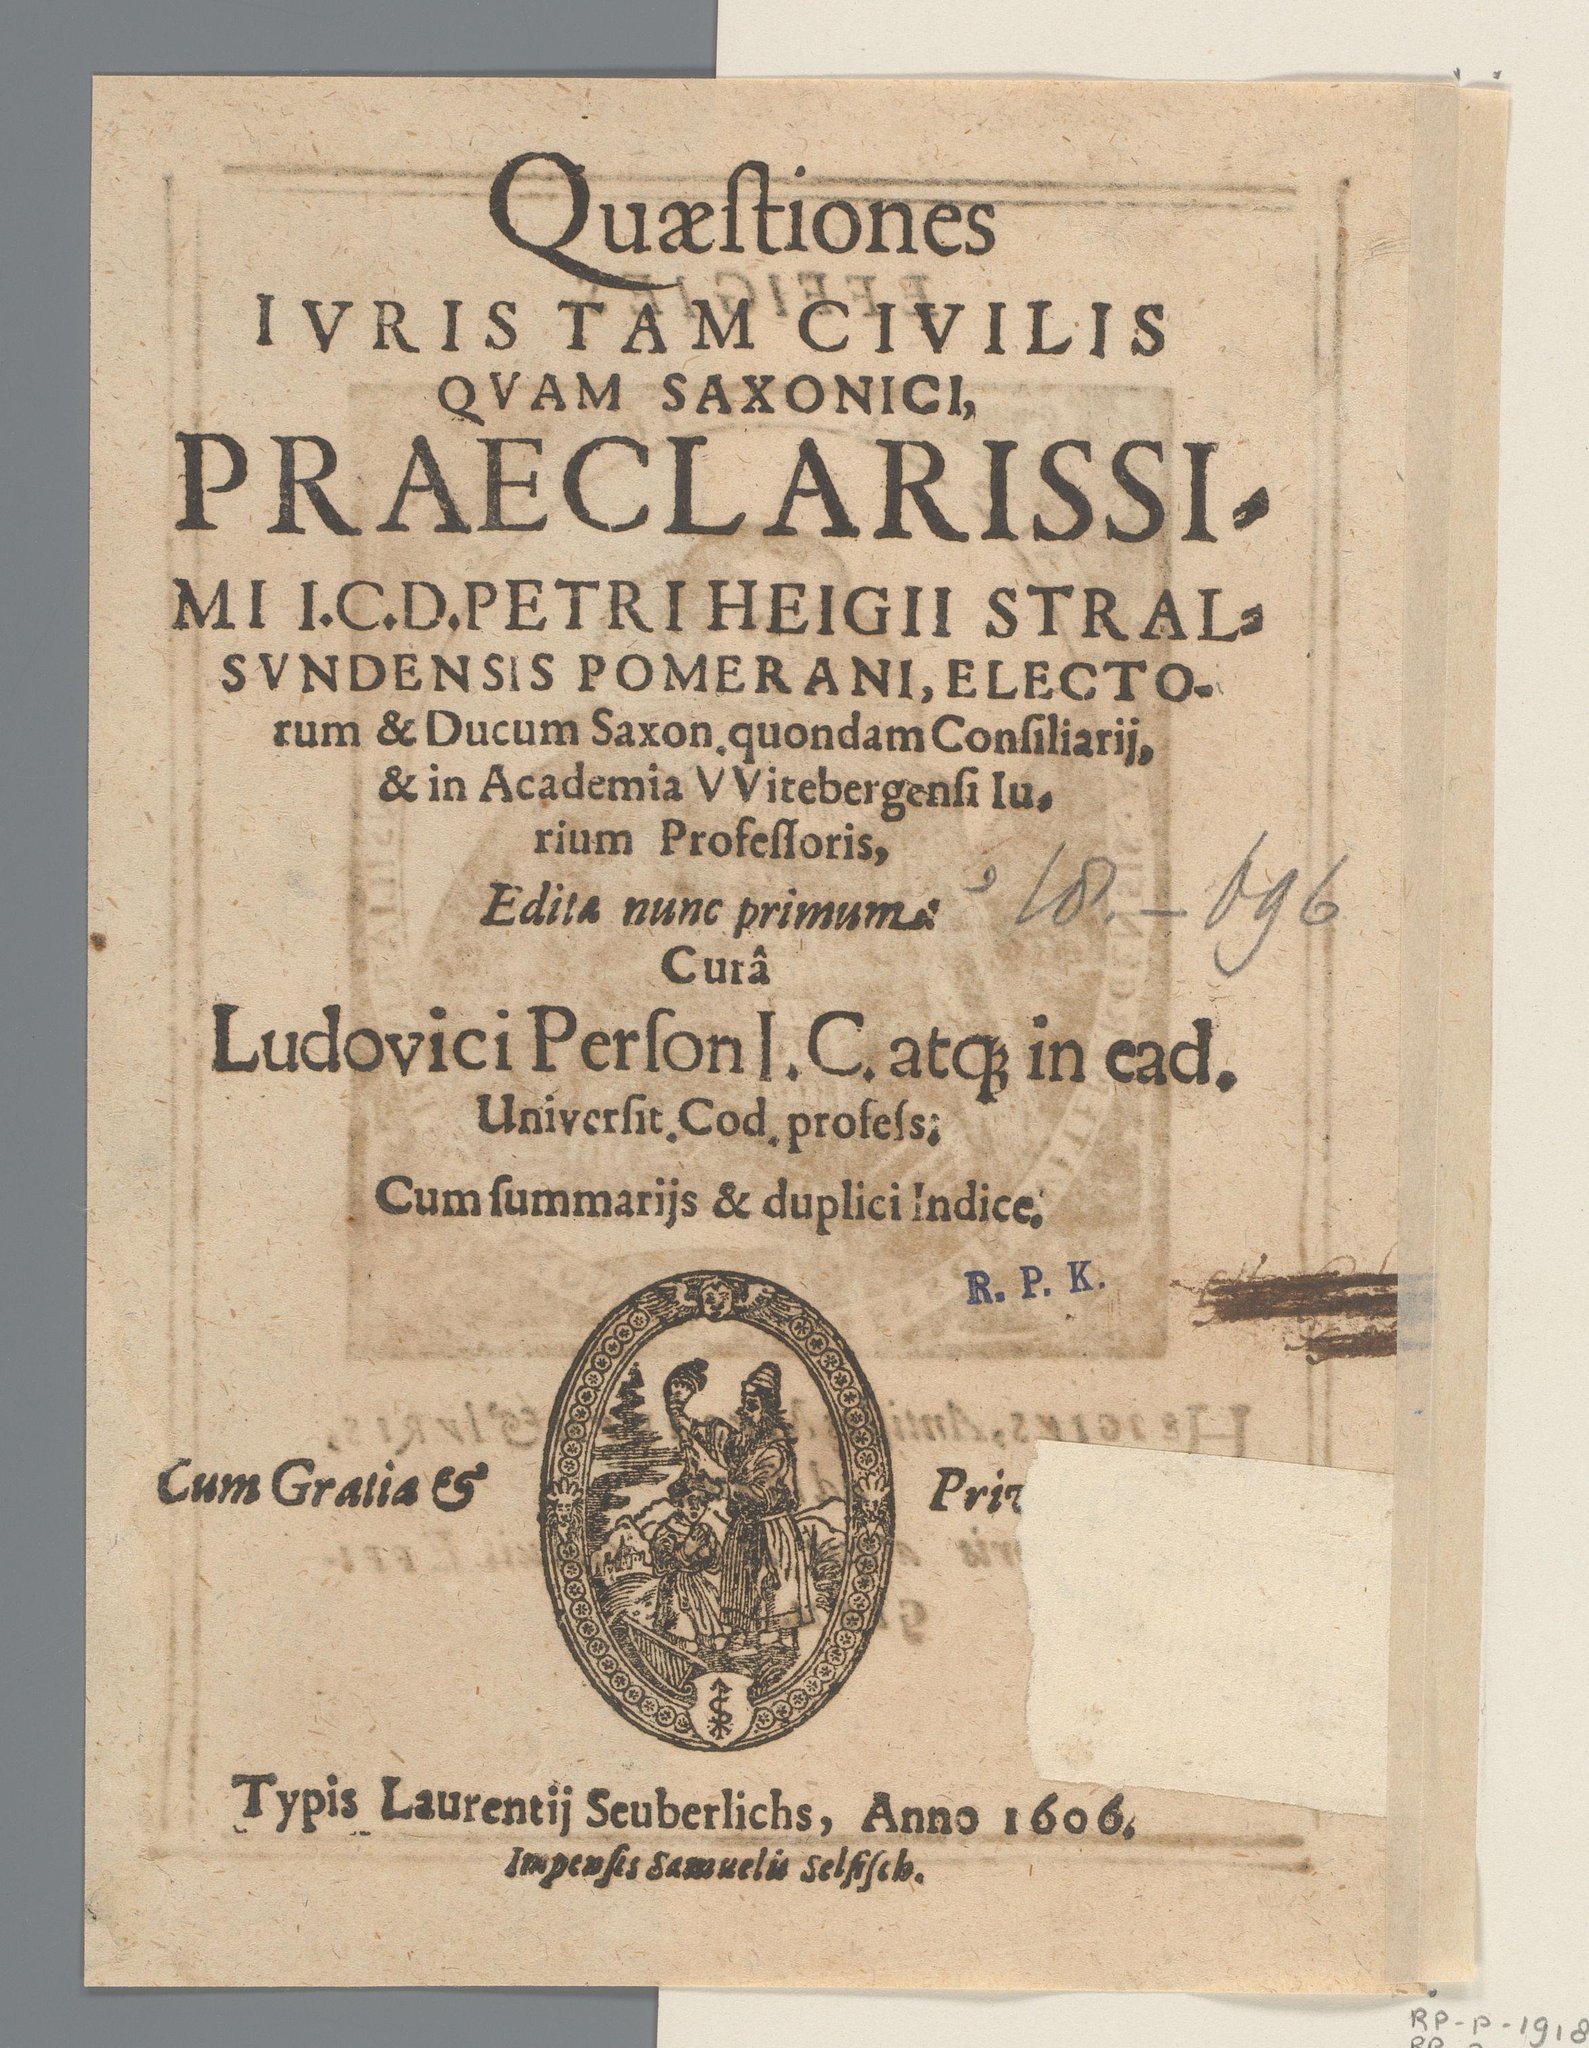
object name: titelblad, titelpagina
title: Titelpagina voor: Peter Heige, Quaestionum juris tam civilis, 1606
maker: lorenz säuberlich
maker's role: printer, publisher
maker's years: -1613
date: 1606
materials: paper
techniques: letterpress printing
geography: wittenberg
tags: device (trade-mark of printer or publisher)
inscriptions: date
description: Titelpagina voor: Heige, Peter. Quaestiones juris ta civilis quam Saxoni, praeclarissimi (...). Wittenberg: Lorenz Säuberlich, 1606.